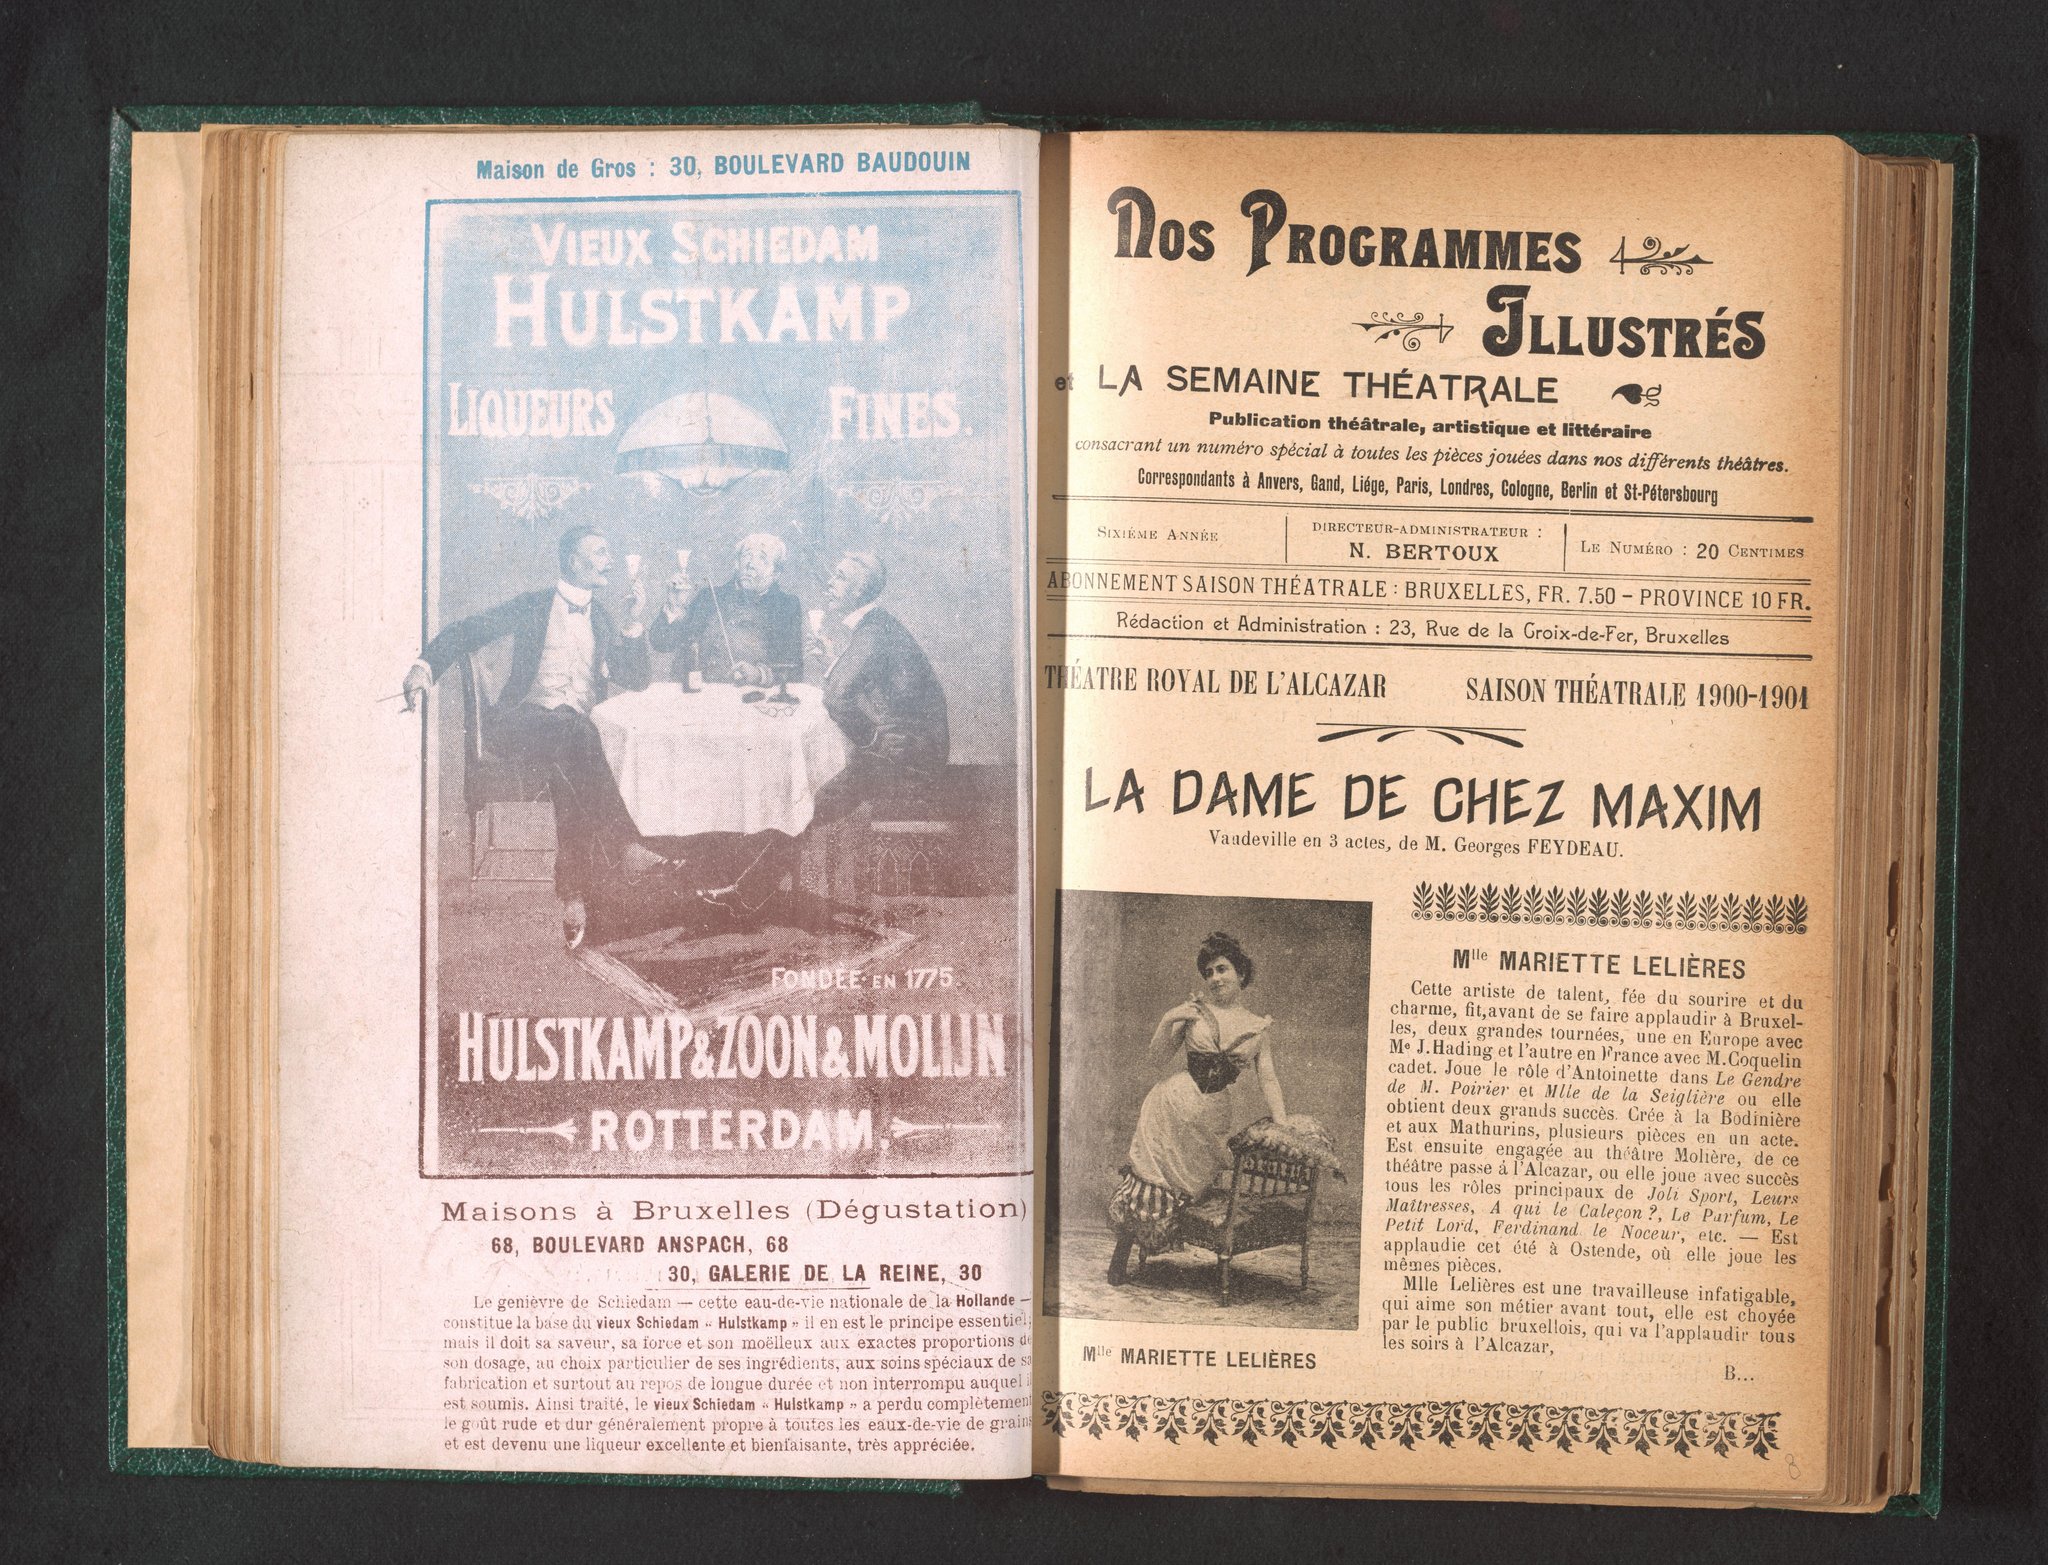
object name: photomechanical print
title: Portret van Mariette Lelières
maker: Anonymous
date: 1895-1900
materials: paper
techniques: autotype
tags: adult woman, historical persons